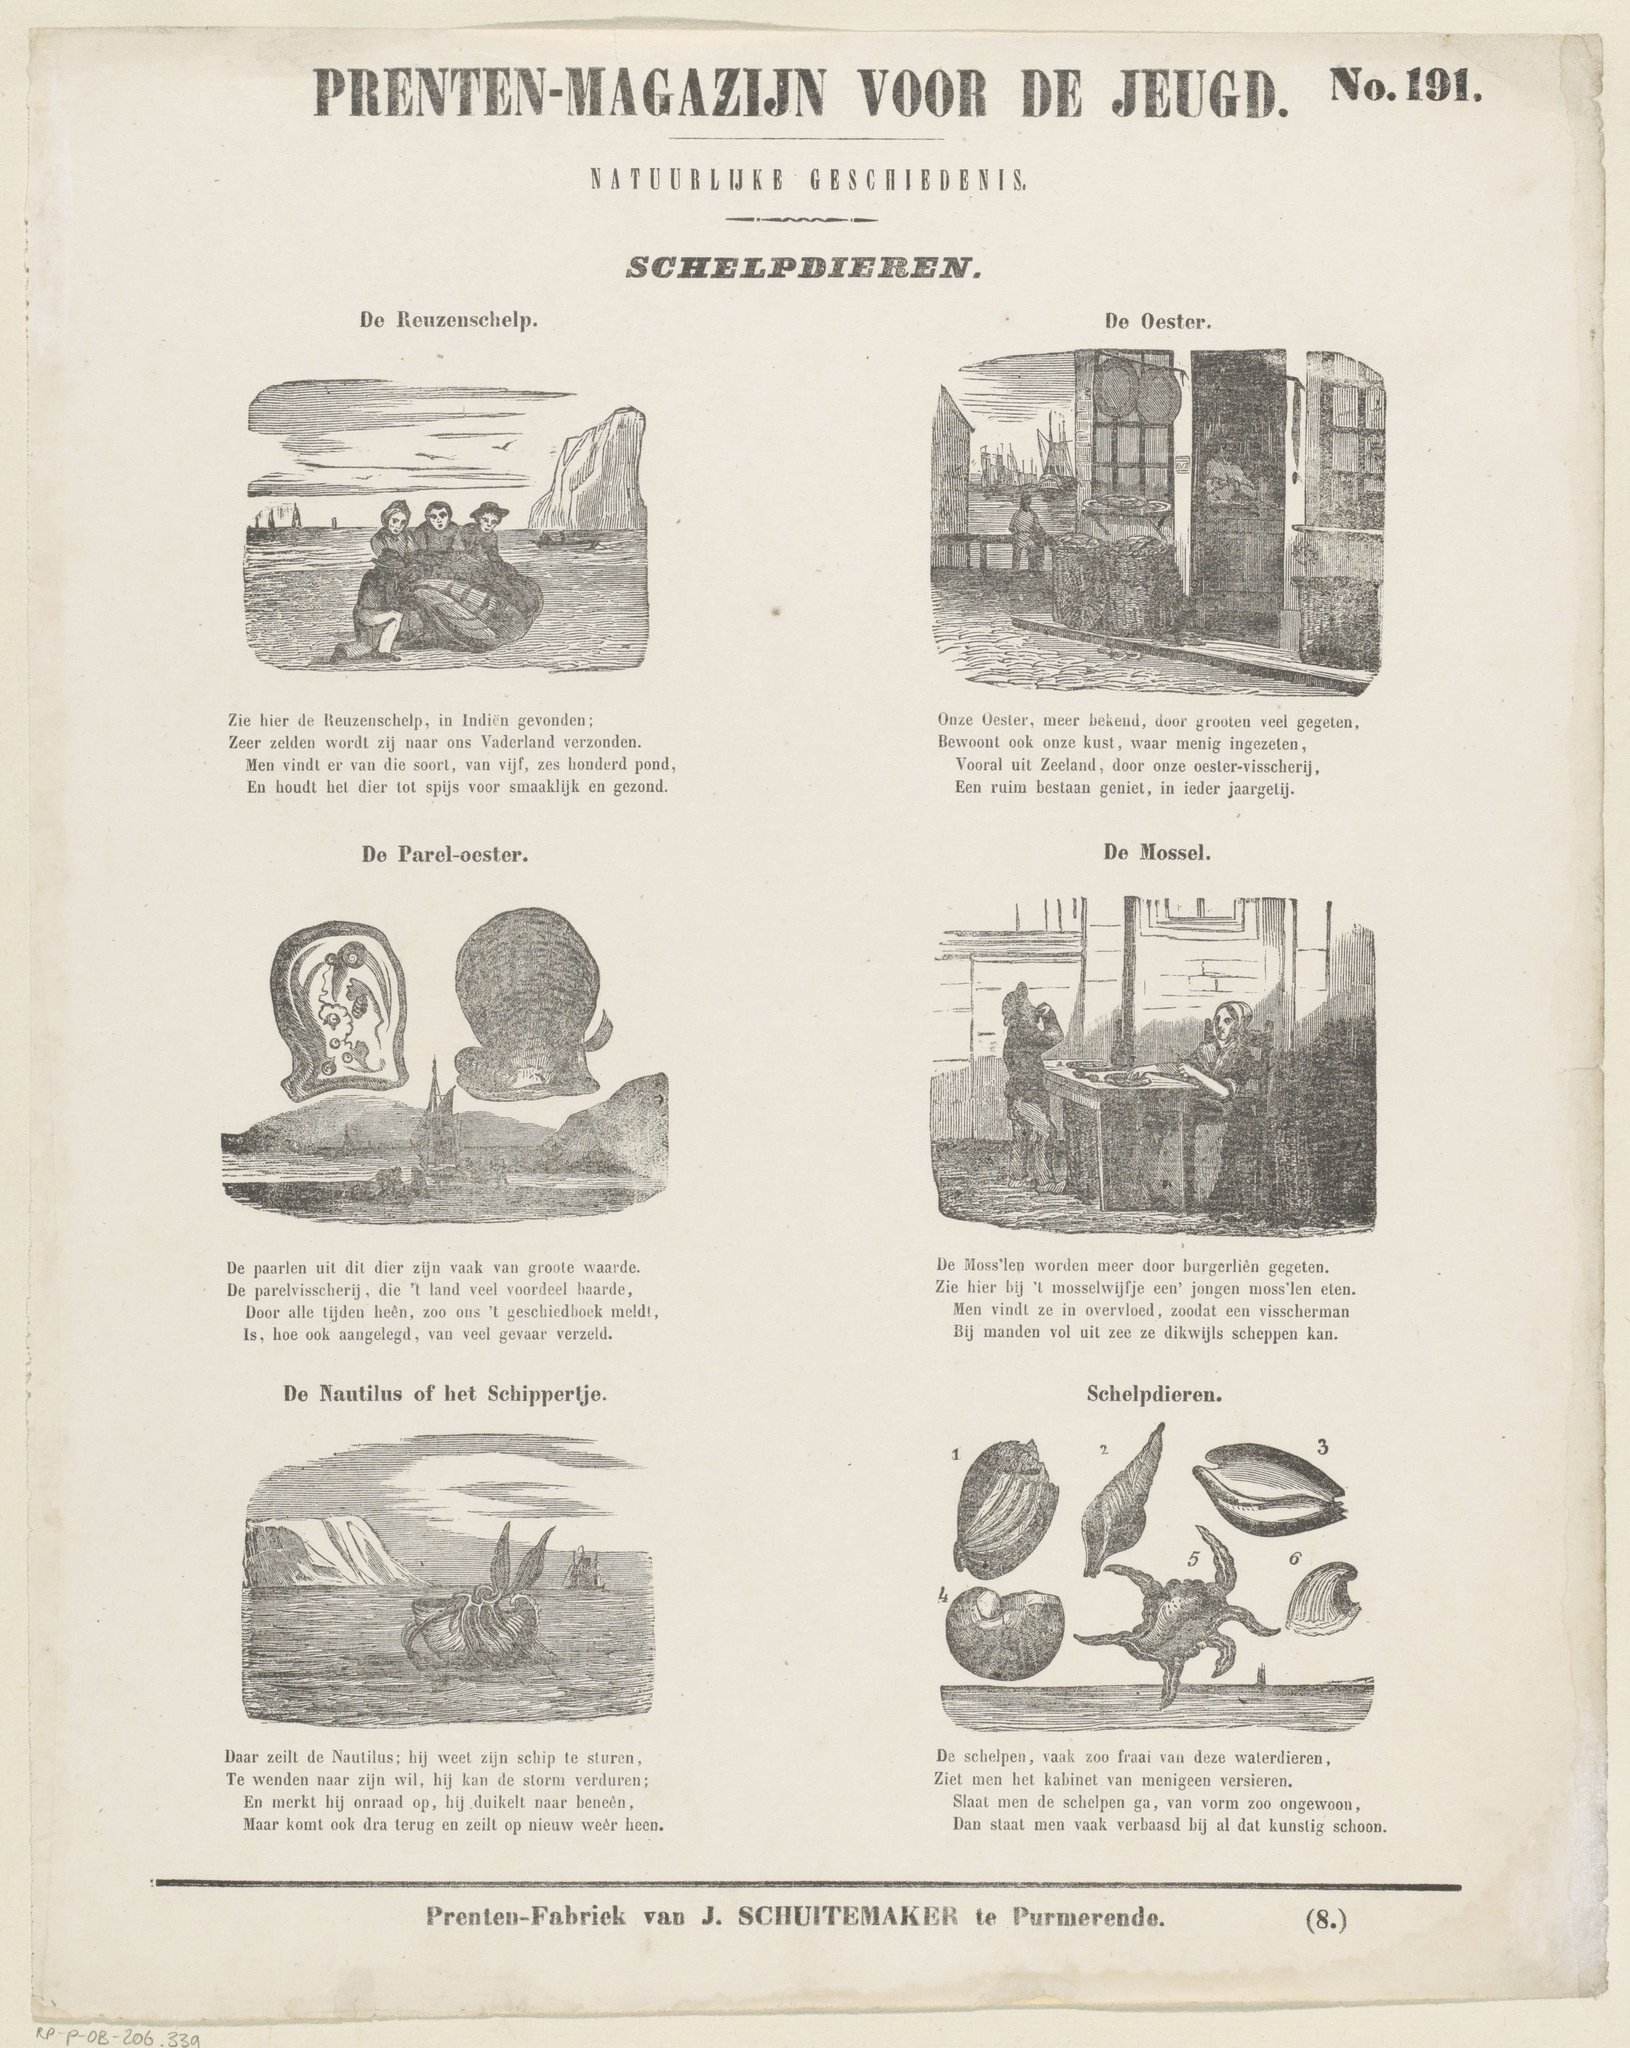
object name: popular print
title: Natuurlijke geschiedenis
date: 1850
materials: paper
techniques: letterpress printing, engraving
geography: purmerend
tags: molluscs: nautilus, molluscs, molluscs: oyster, molluscs: mussel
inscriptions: collector's mark: Lugt 2760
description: Na voltooiing van de acht jaargangen van de reeks 'Prenten-magazijn voor de jeugd' in 1850 heeft Jan Schuitemaker al deze prenten heruitgegeven en omgenummerd als nr. 1 t/m 192. De oorspronkelijke jaargang wordt telkens nog vermeld rechtsonder op de prent. Binnen de jaargangen zijn prenten van hetzelfde thema in clusters van vier achter elkaar gezet.